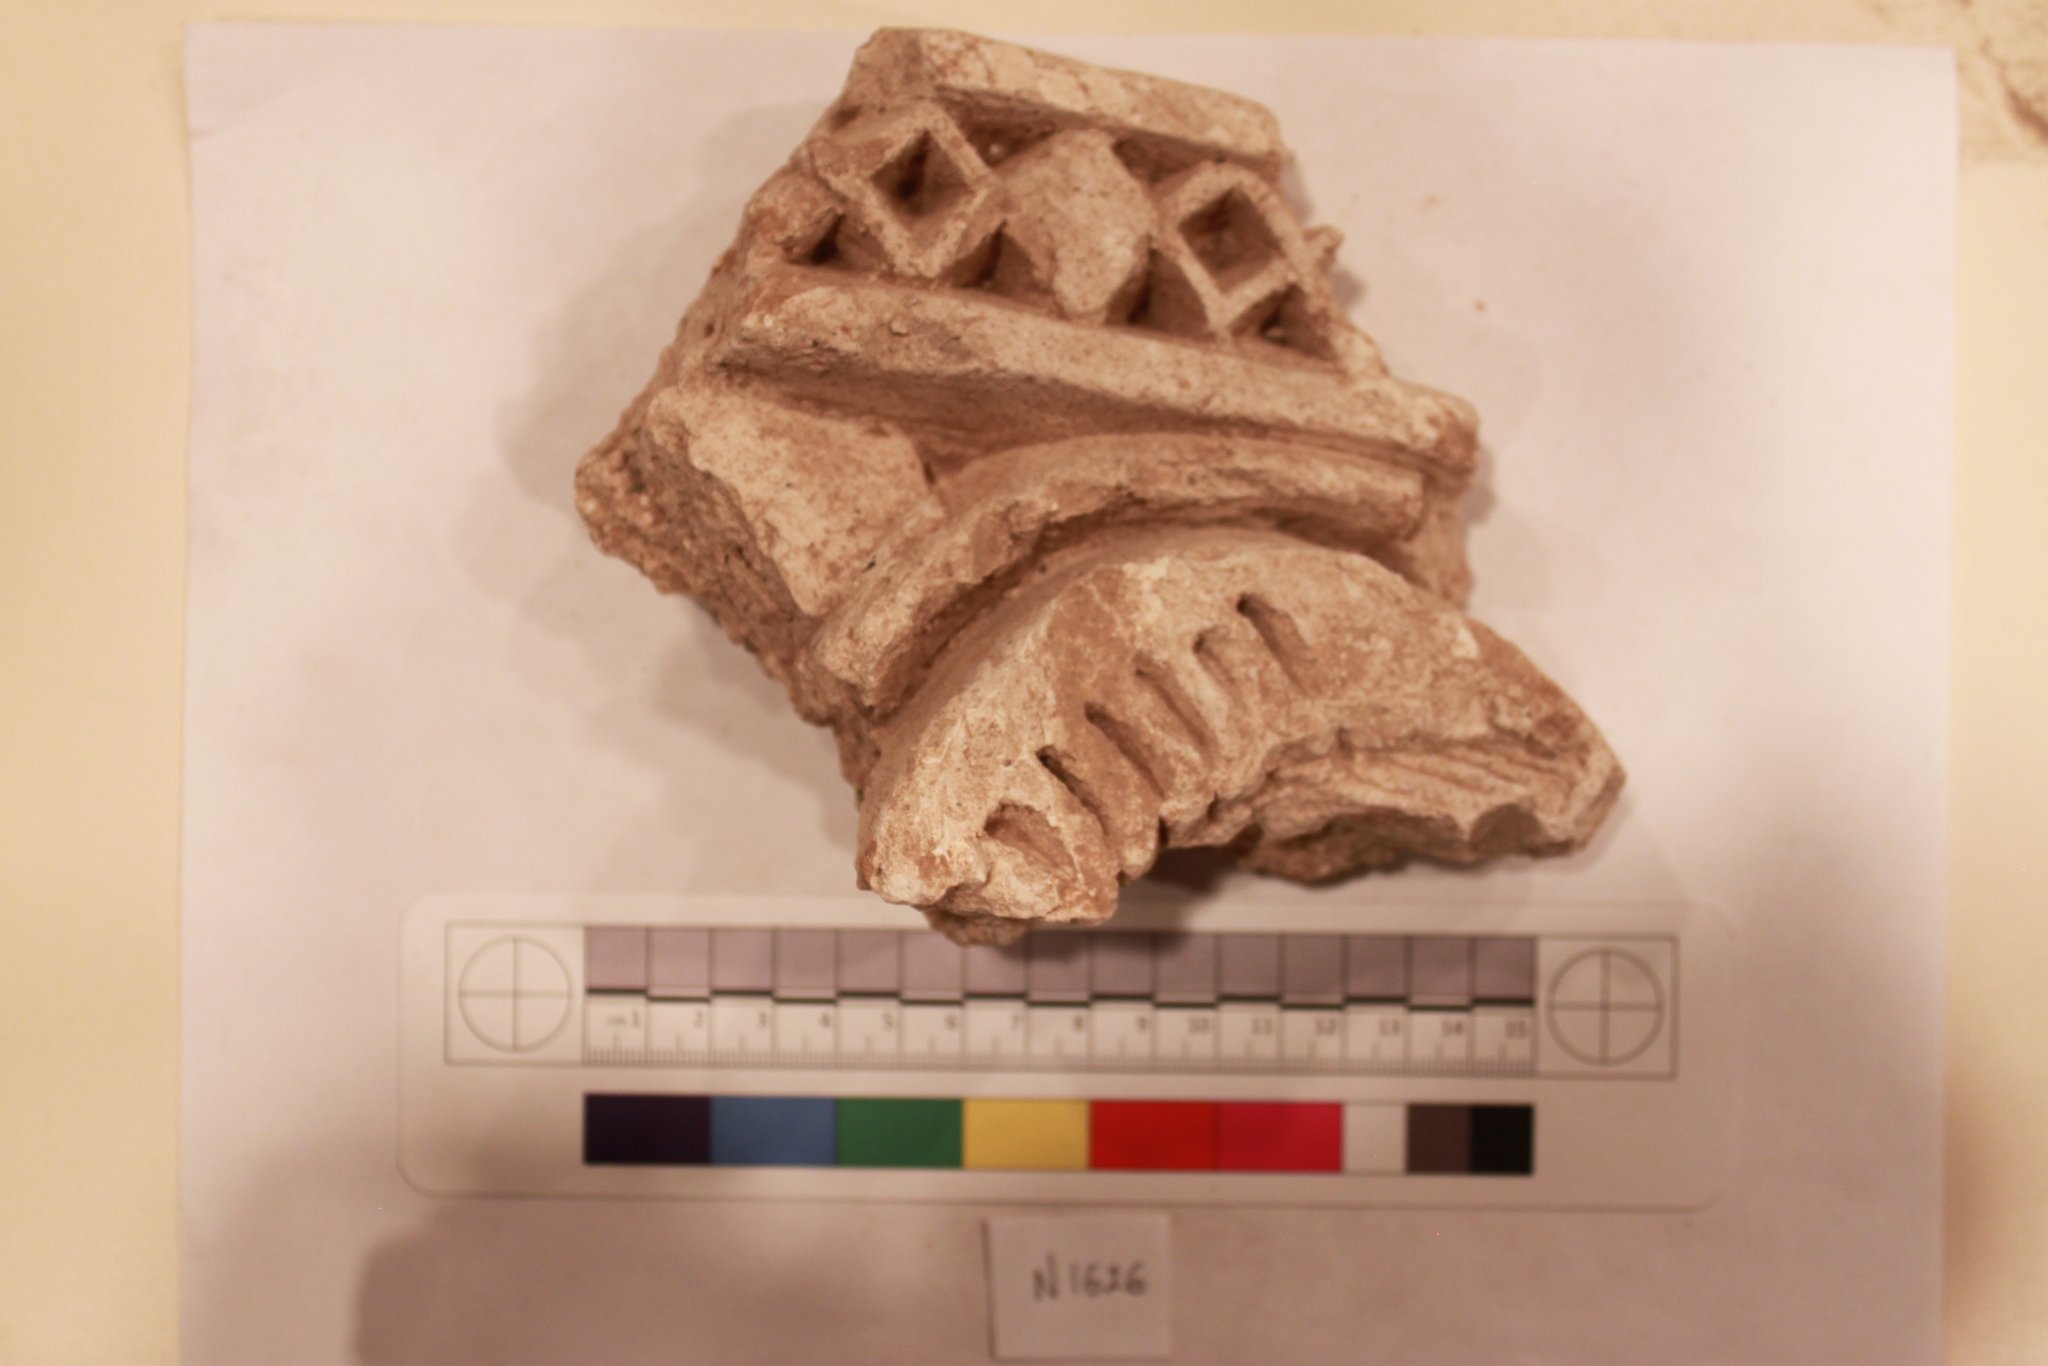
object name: fragment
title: Stucco Fragment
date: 701-1200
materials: plaster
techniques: carving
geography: iran